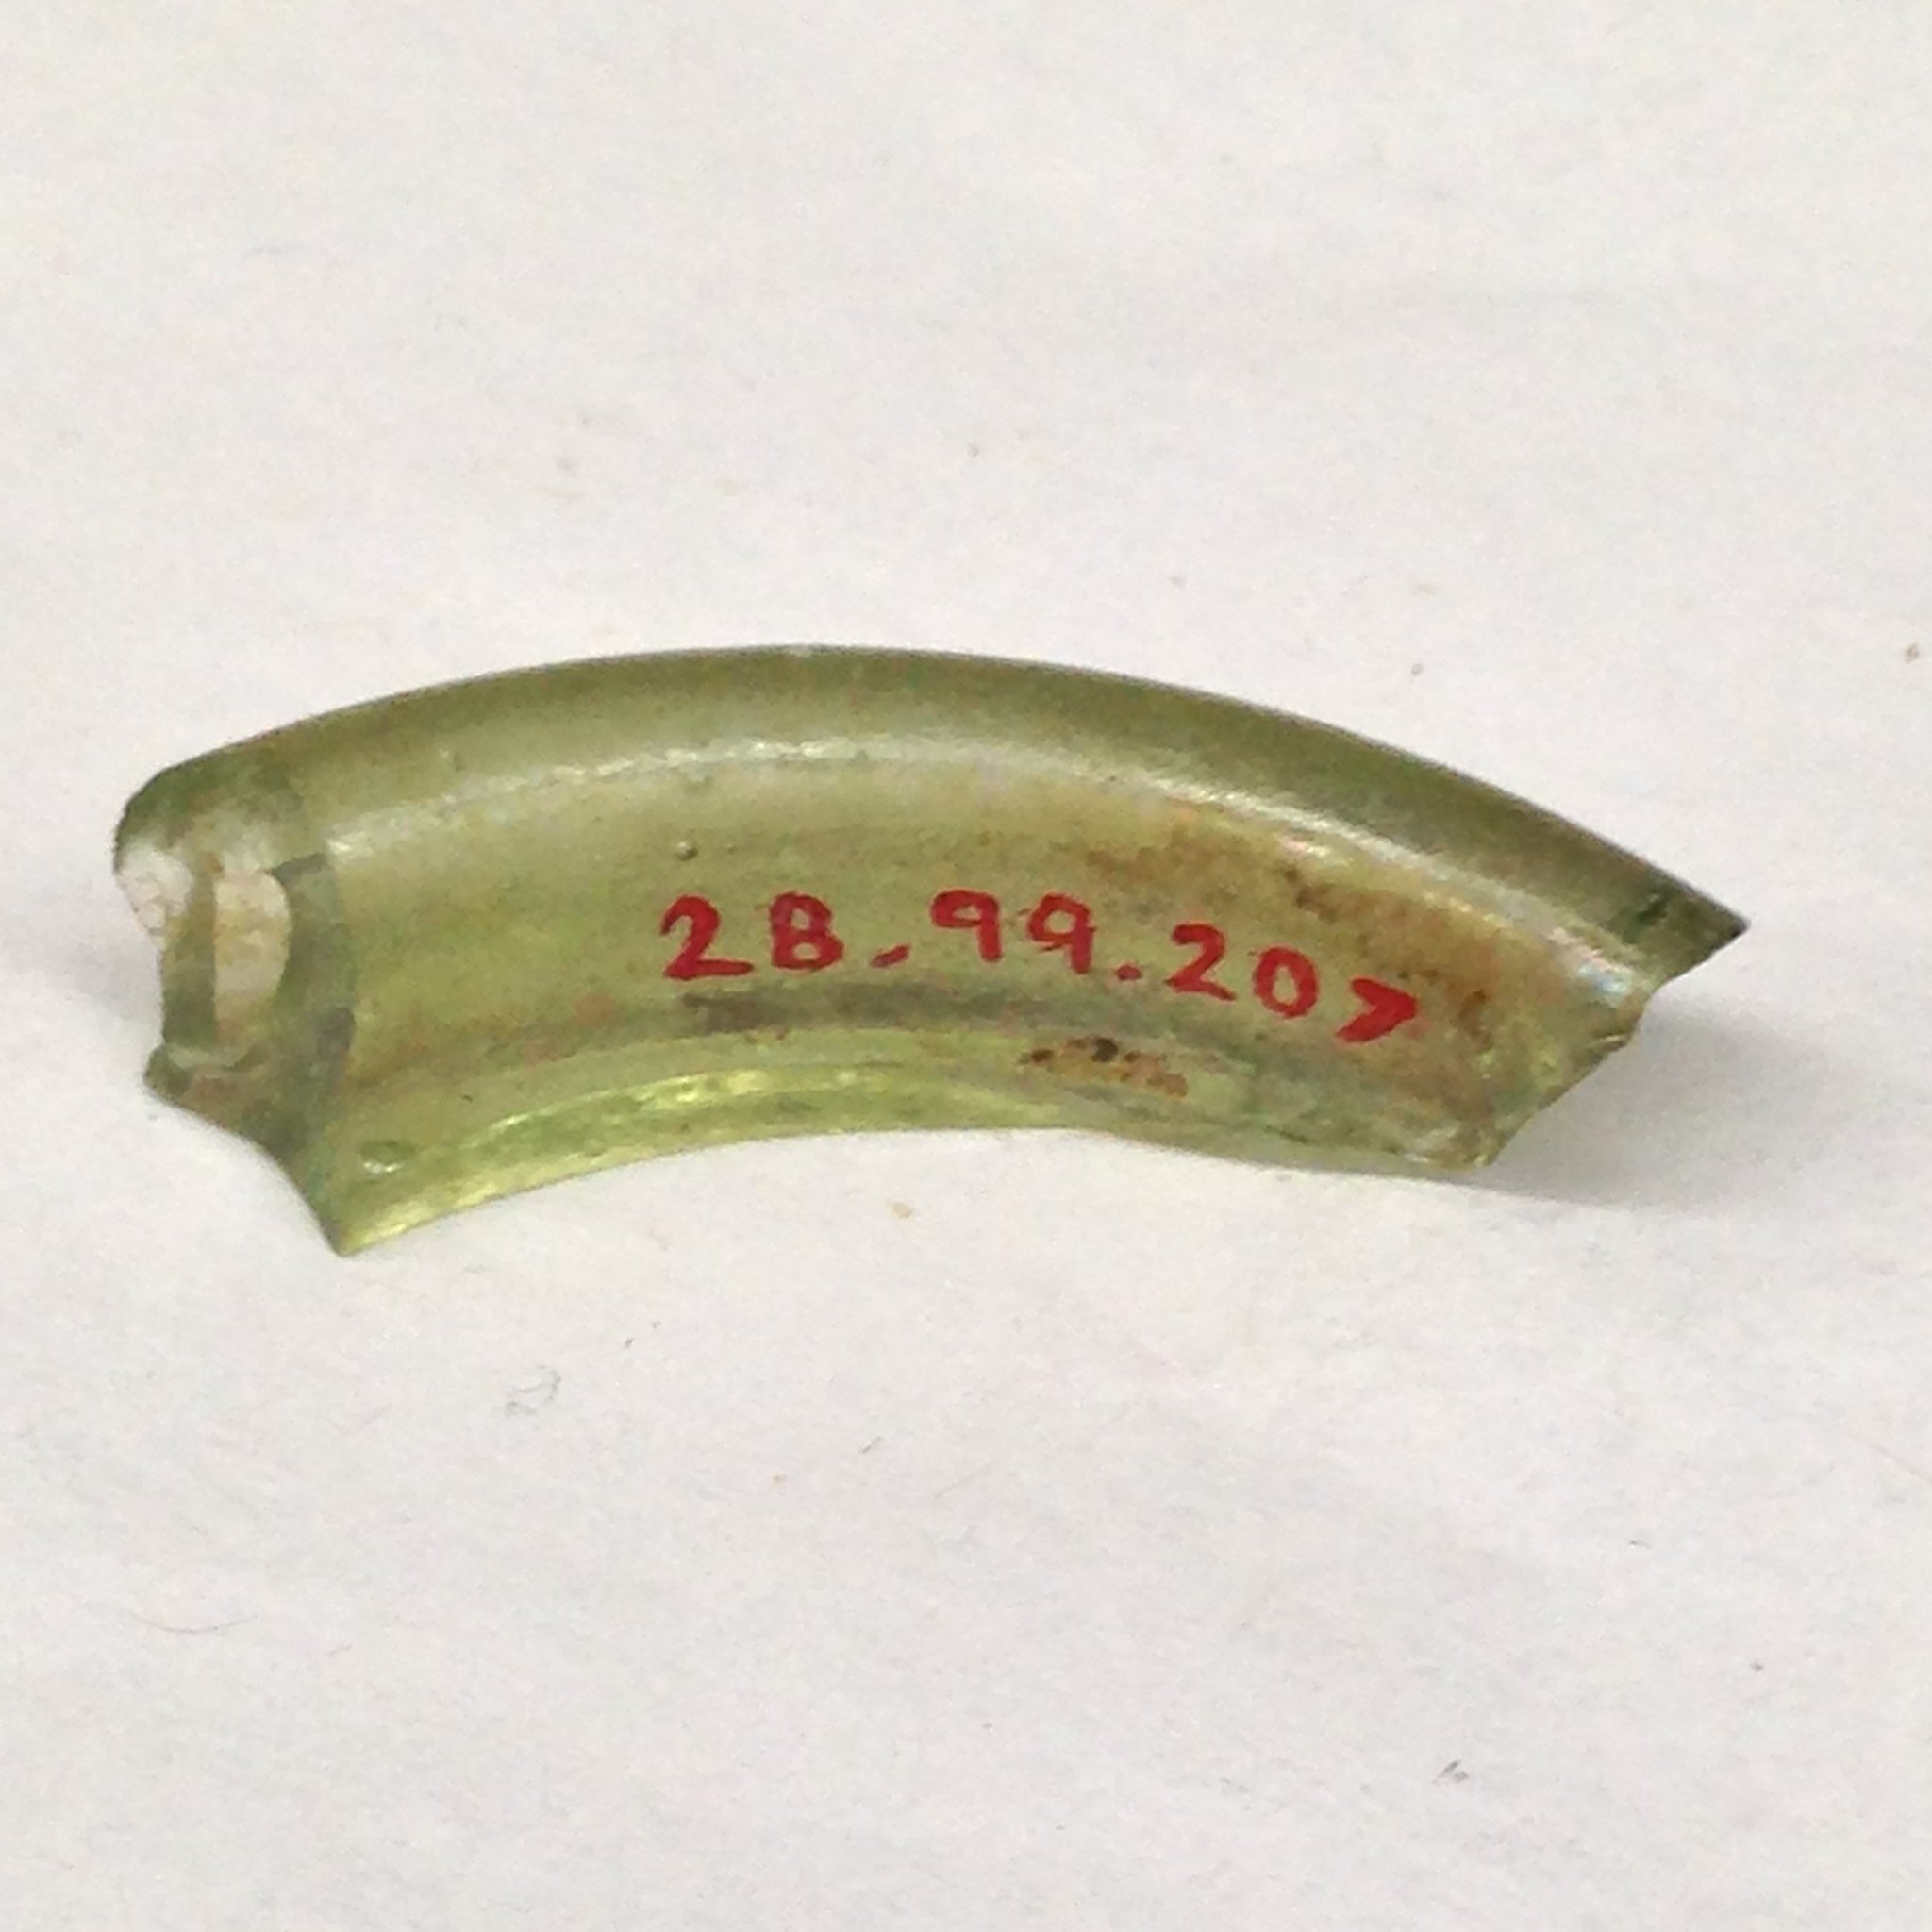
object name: fragment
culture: european or middle eastern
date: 1150-1250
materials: ceramic, glass